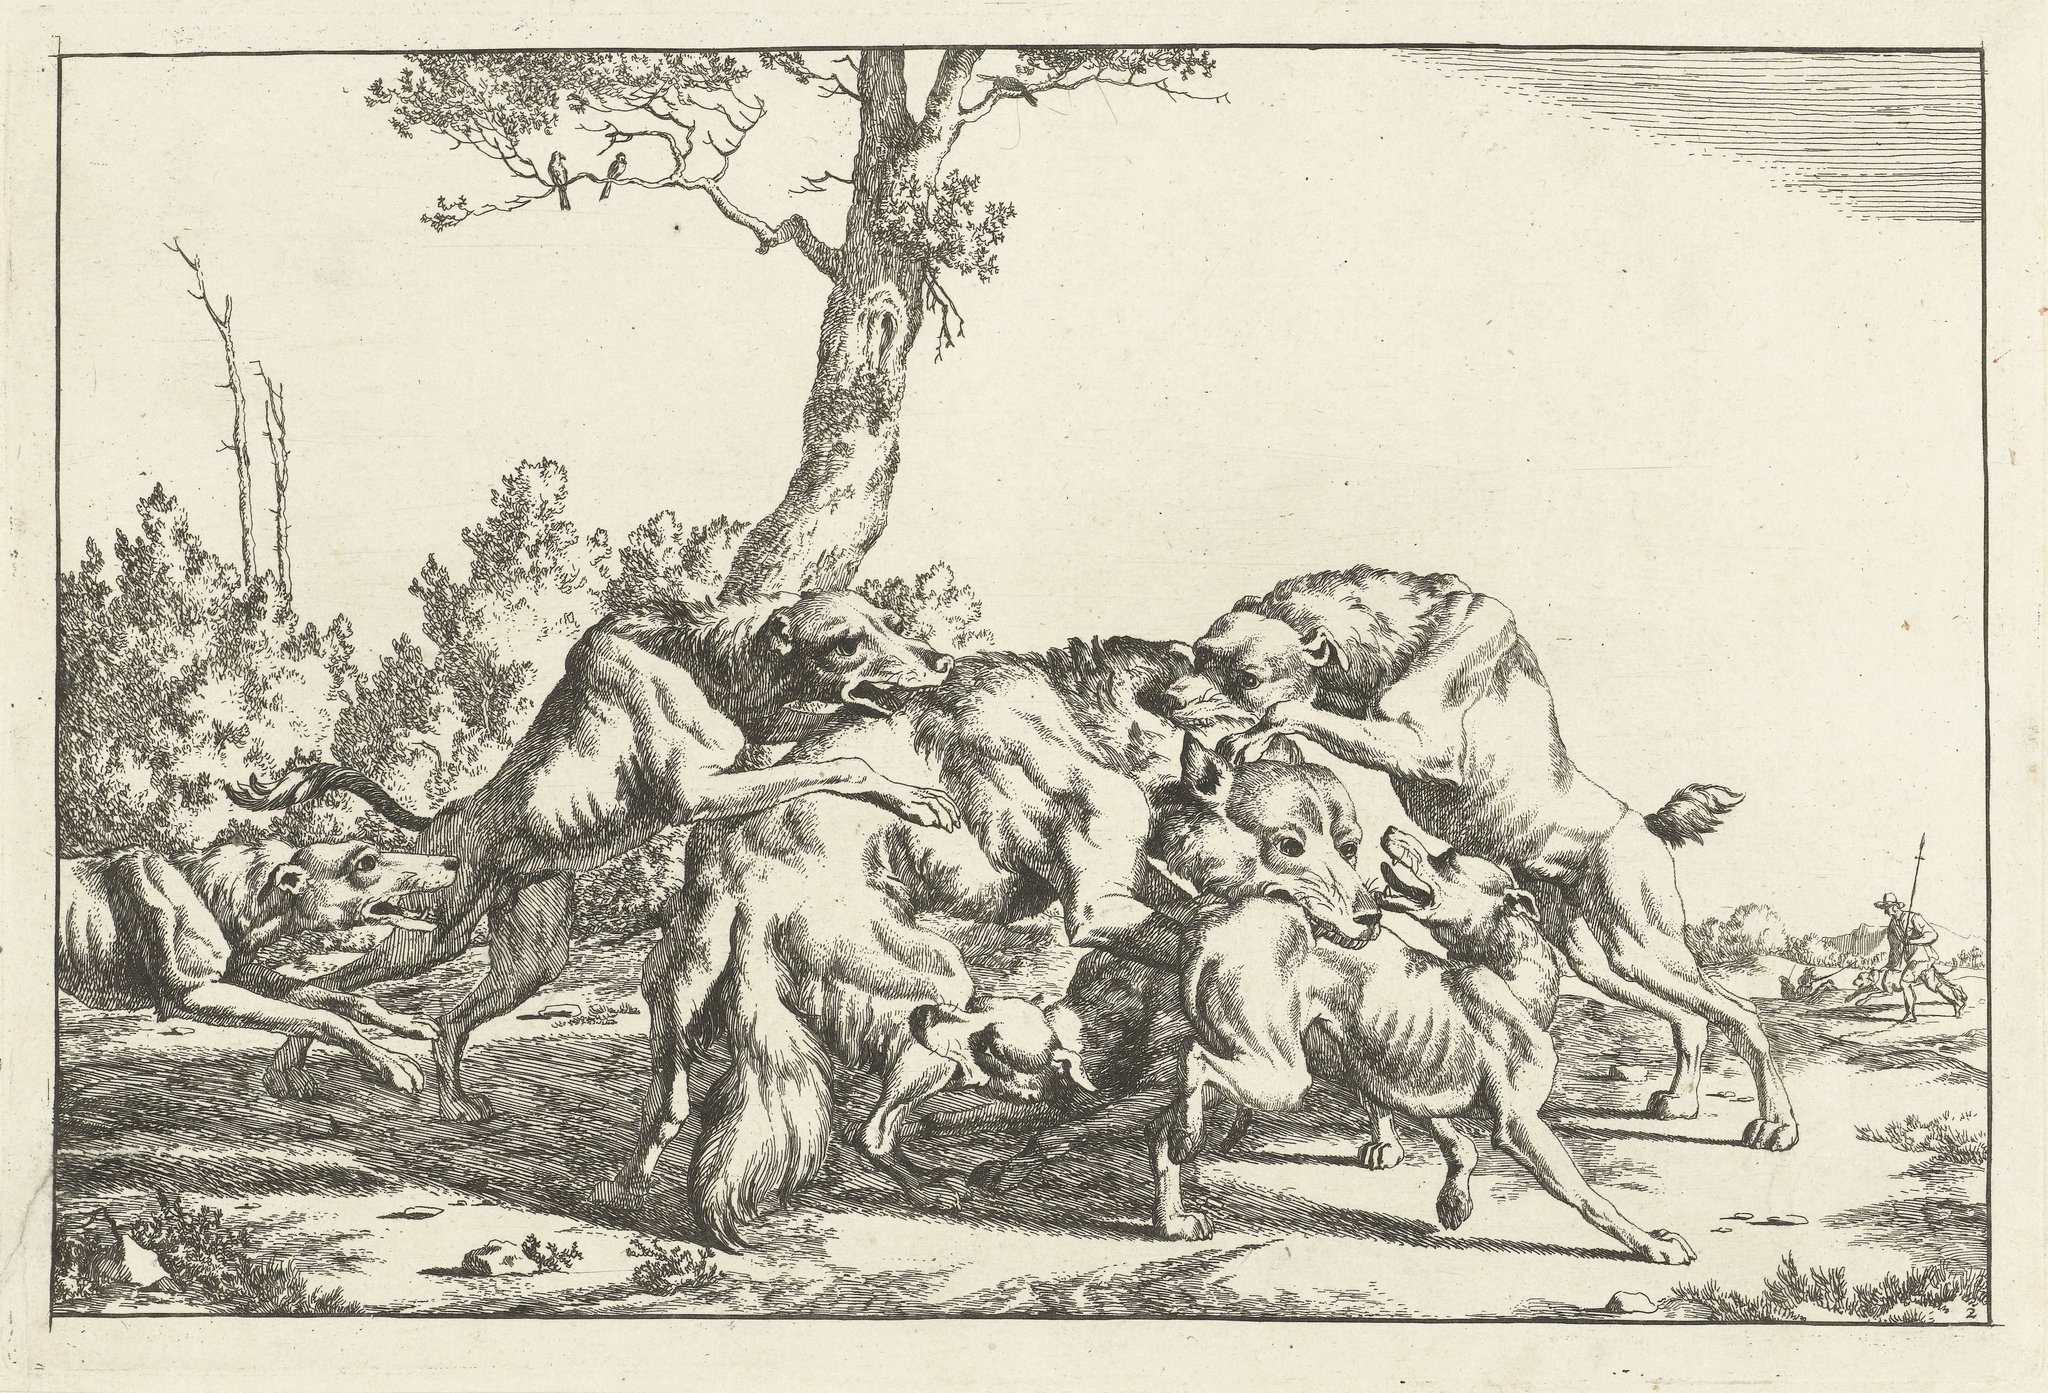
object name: print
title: Wolf aangevallen door vijf jachthonden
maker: marcus de bye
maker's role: print maker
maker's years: 1639-1688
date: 1657-1677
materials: paper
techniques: etching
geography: the hague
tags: hunting, chase, hunting dogs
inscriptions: collector's mark: Lugt 240